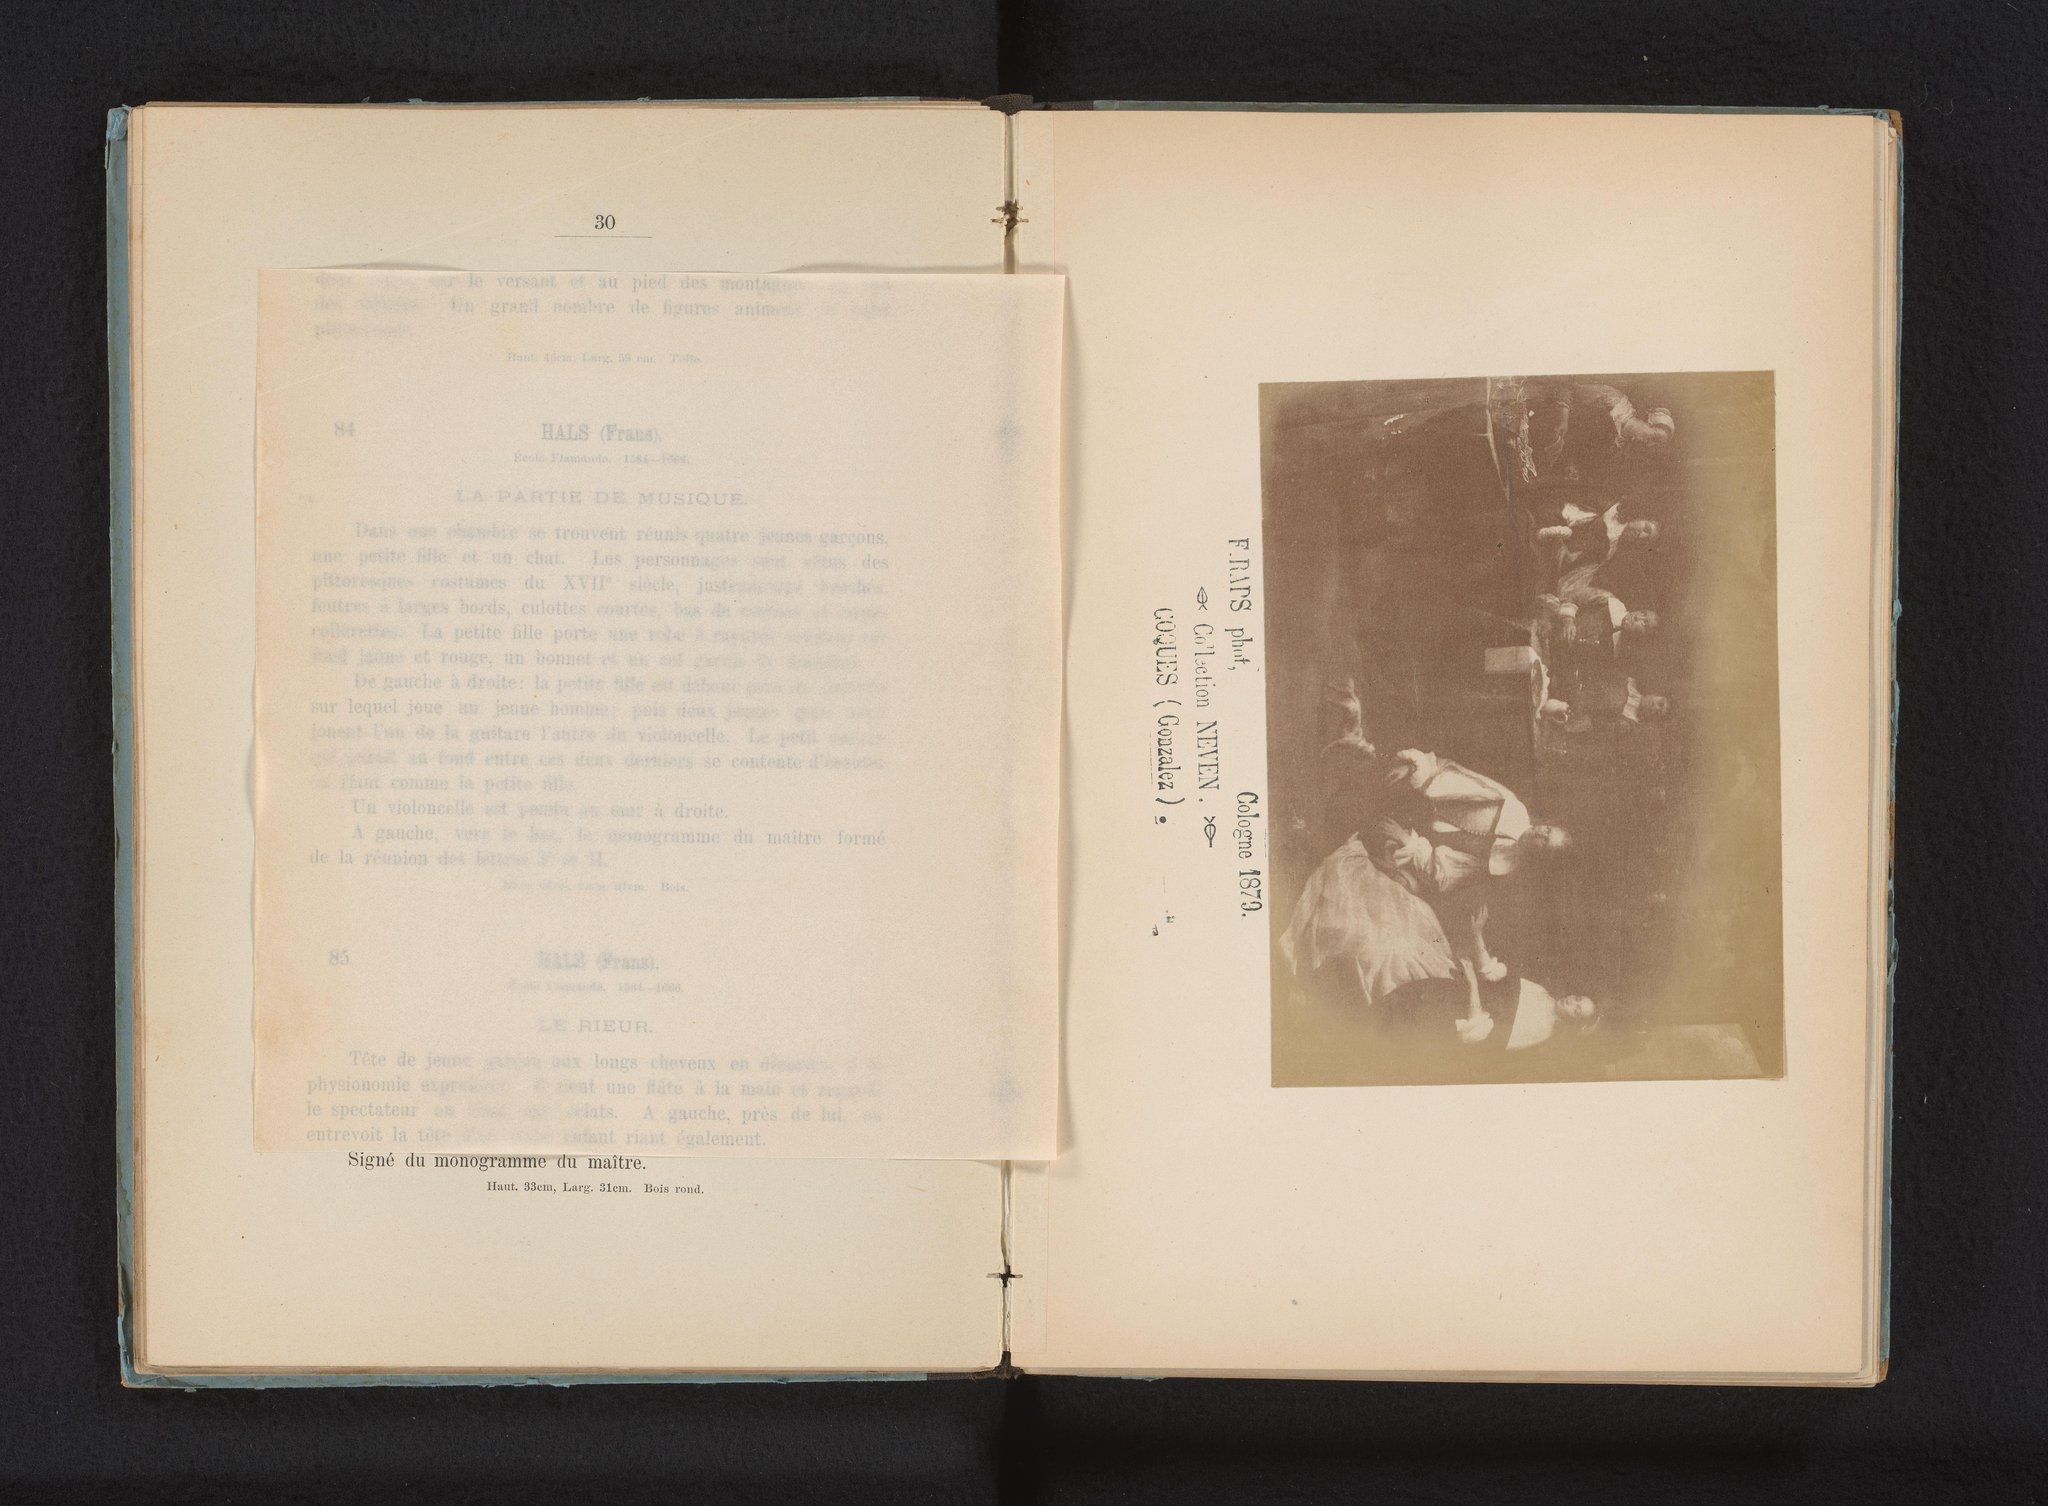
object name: page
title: Fotoreproductie van een schilderij van drie mannen aan tafel met een bediende en een knielende schoenmaker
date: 1879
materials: photographic support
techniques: albumen print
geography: cologne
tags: shoe-maker, cobbler, house personnel, servants, dog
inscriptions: inscription: ‘Collection NEVEN/ Coques (Gonzalez)’